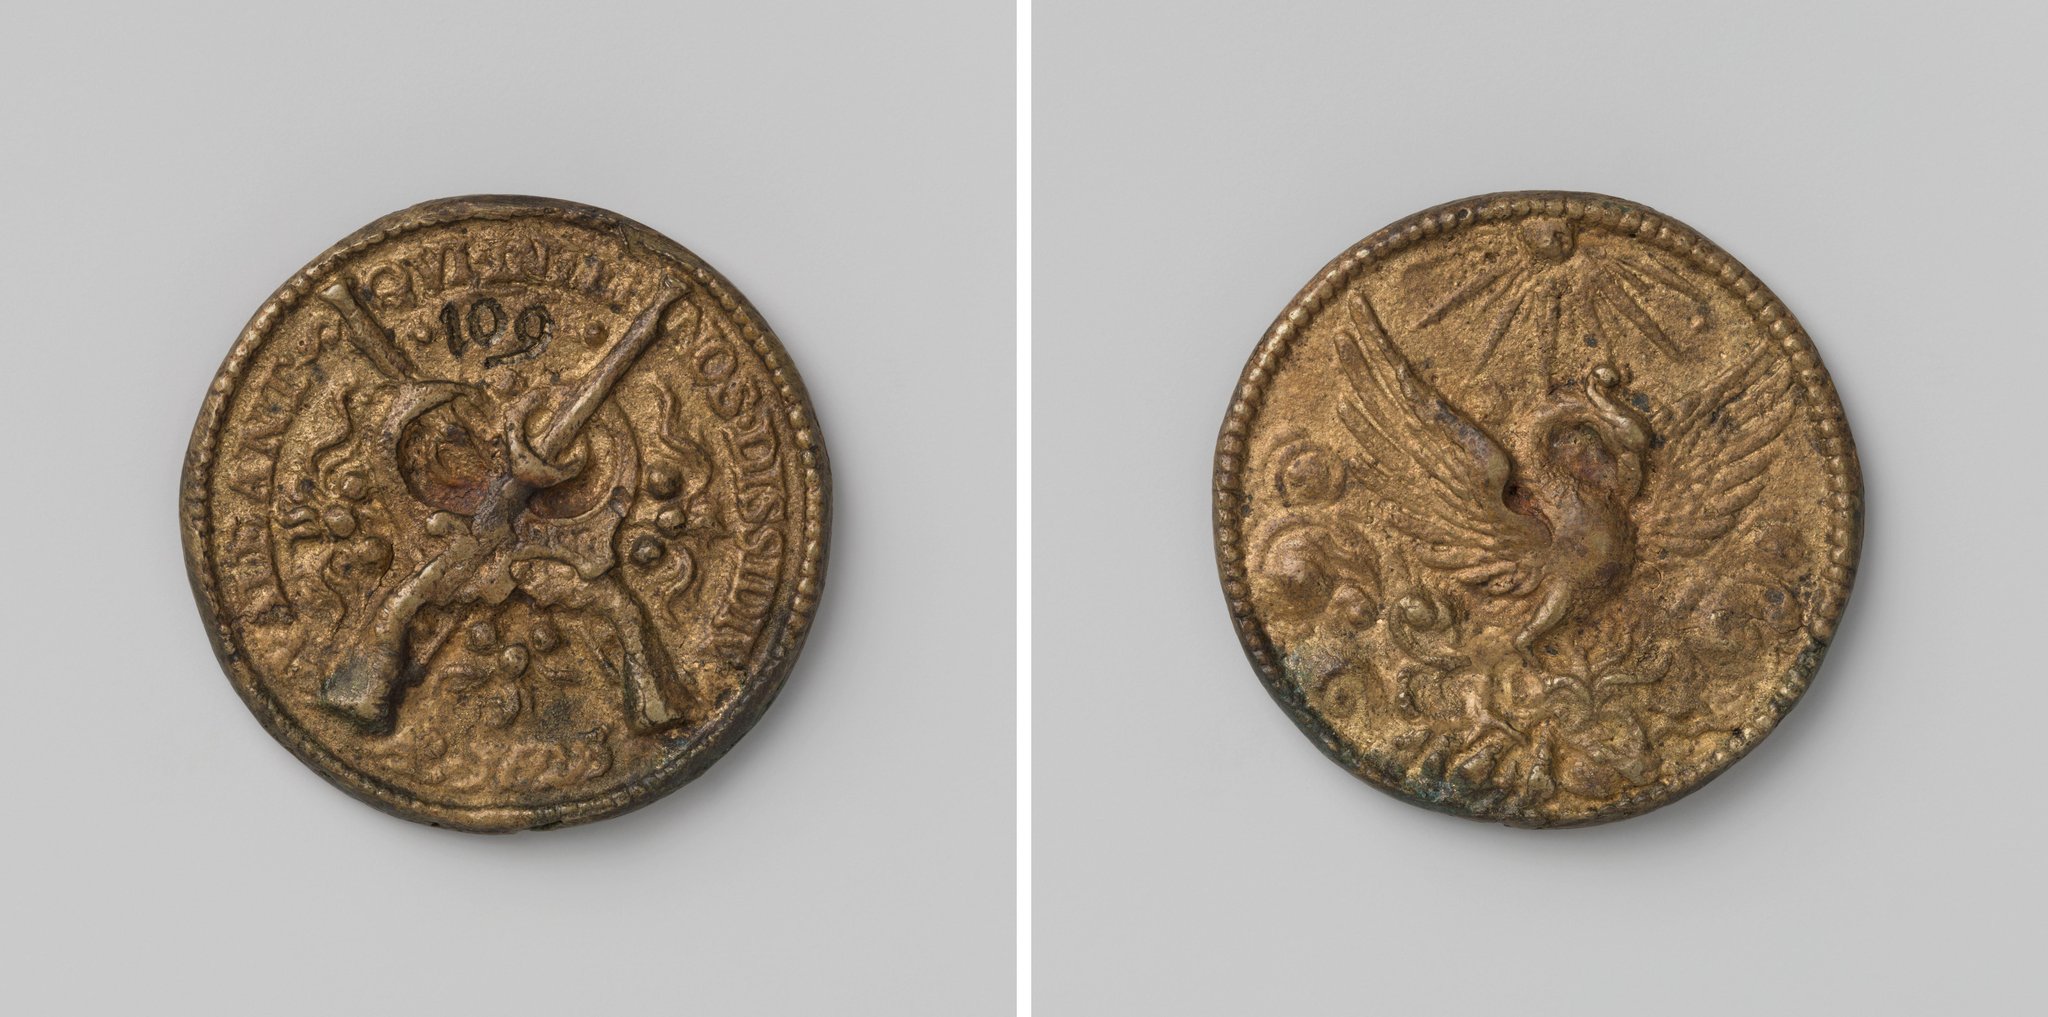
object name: marksman medal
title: Confrerie van de Edele Busse te Middelburg, schutterspenning met no. 109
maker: johannes looff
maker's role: die cutter, draughtsman, print maker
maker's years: -1651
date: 1623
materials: brass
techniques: casting, engraving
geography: middelburg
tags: middelburg